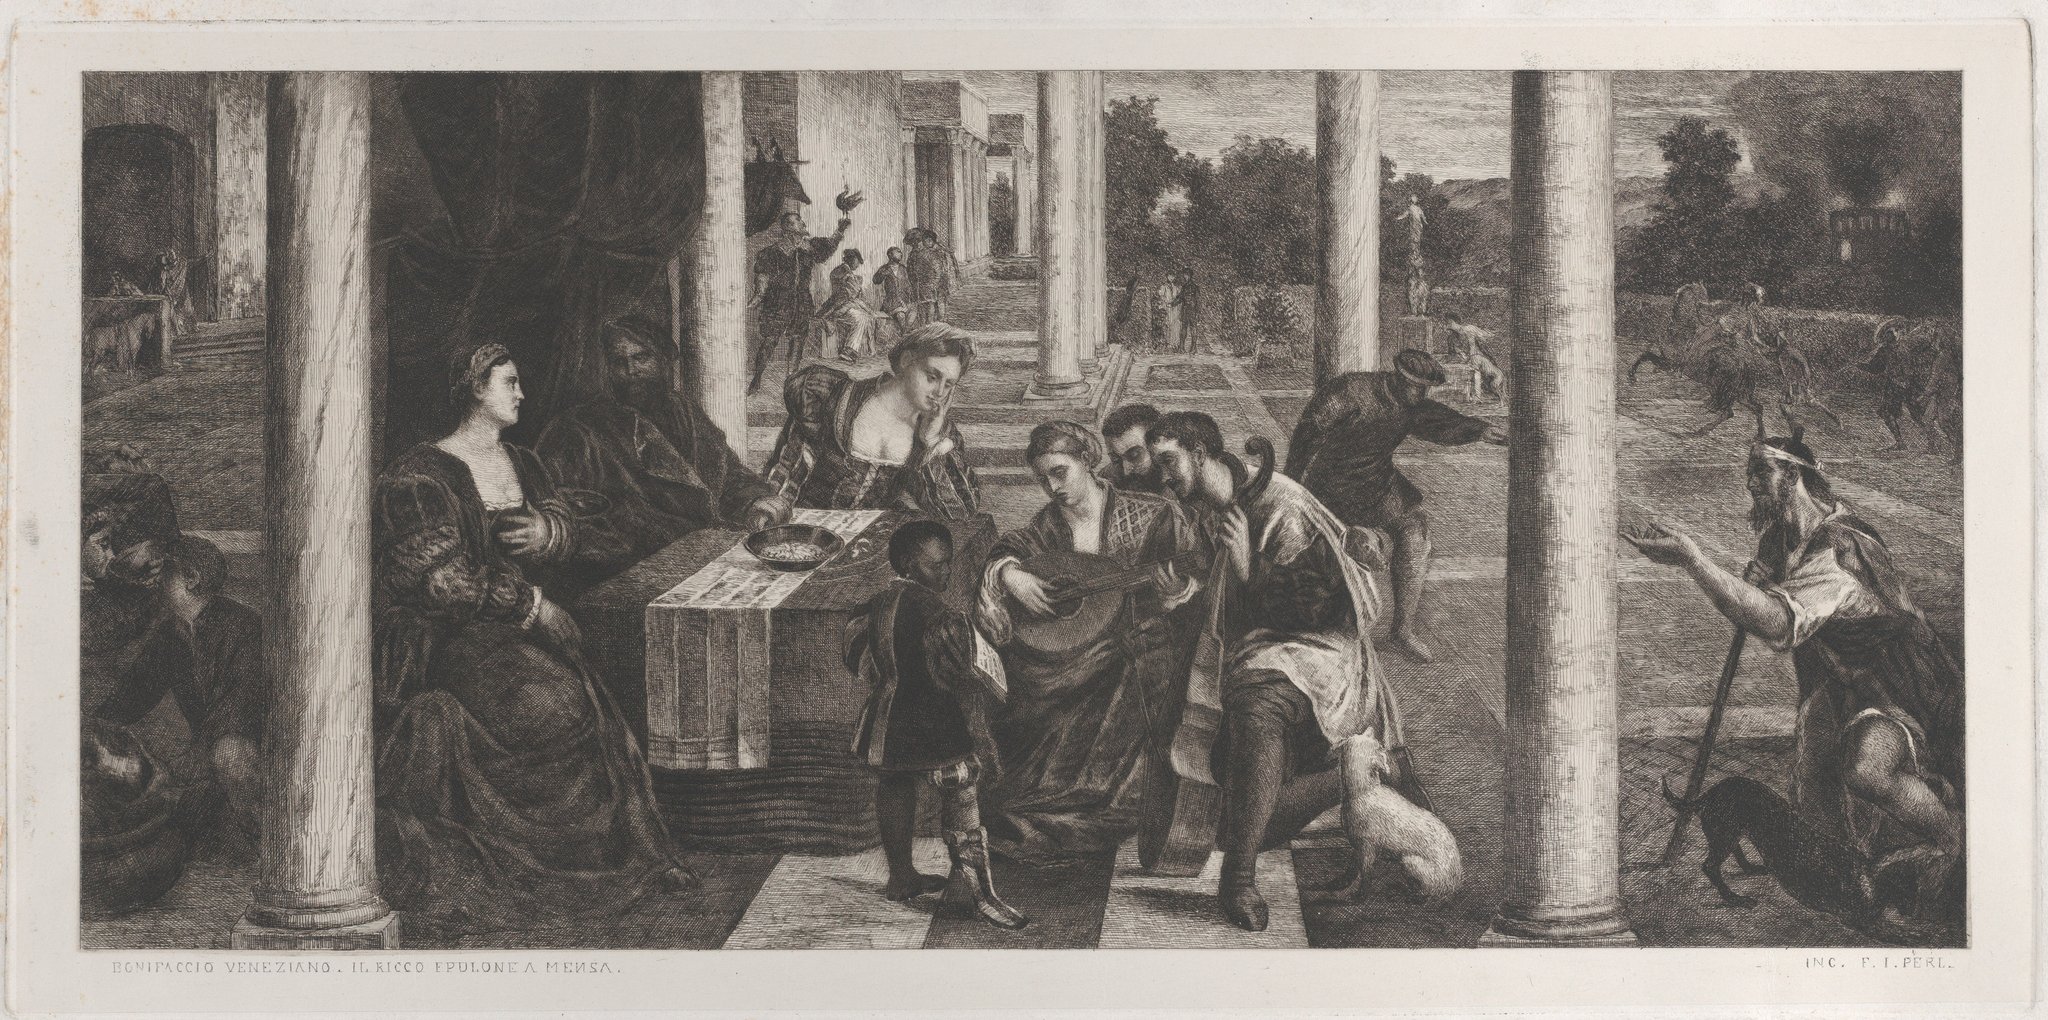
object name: print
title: The parable of the rich man (Dives) and Lazarus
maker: Anonymous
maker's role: artist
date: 1700-1800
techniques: engraving